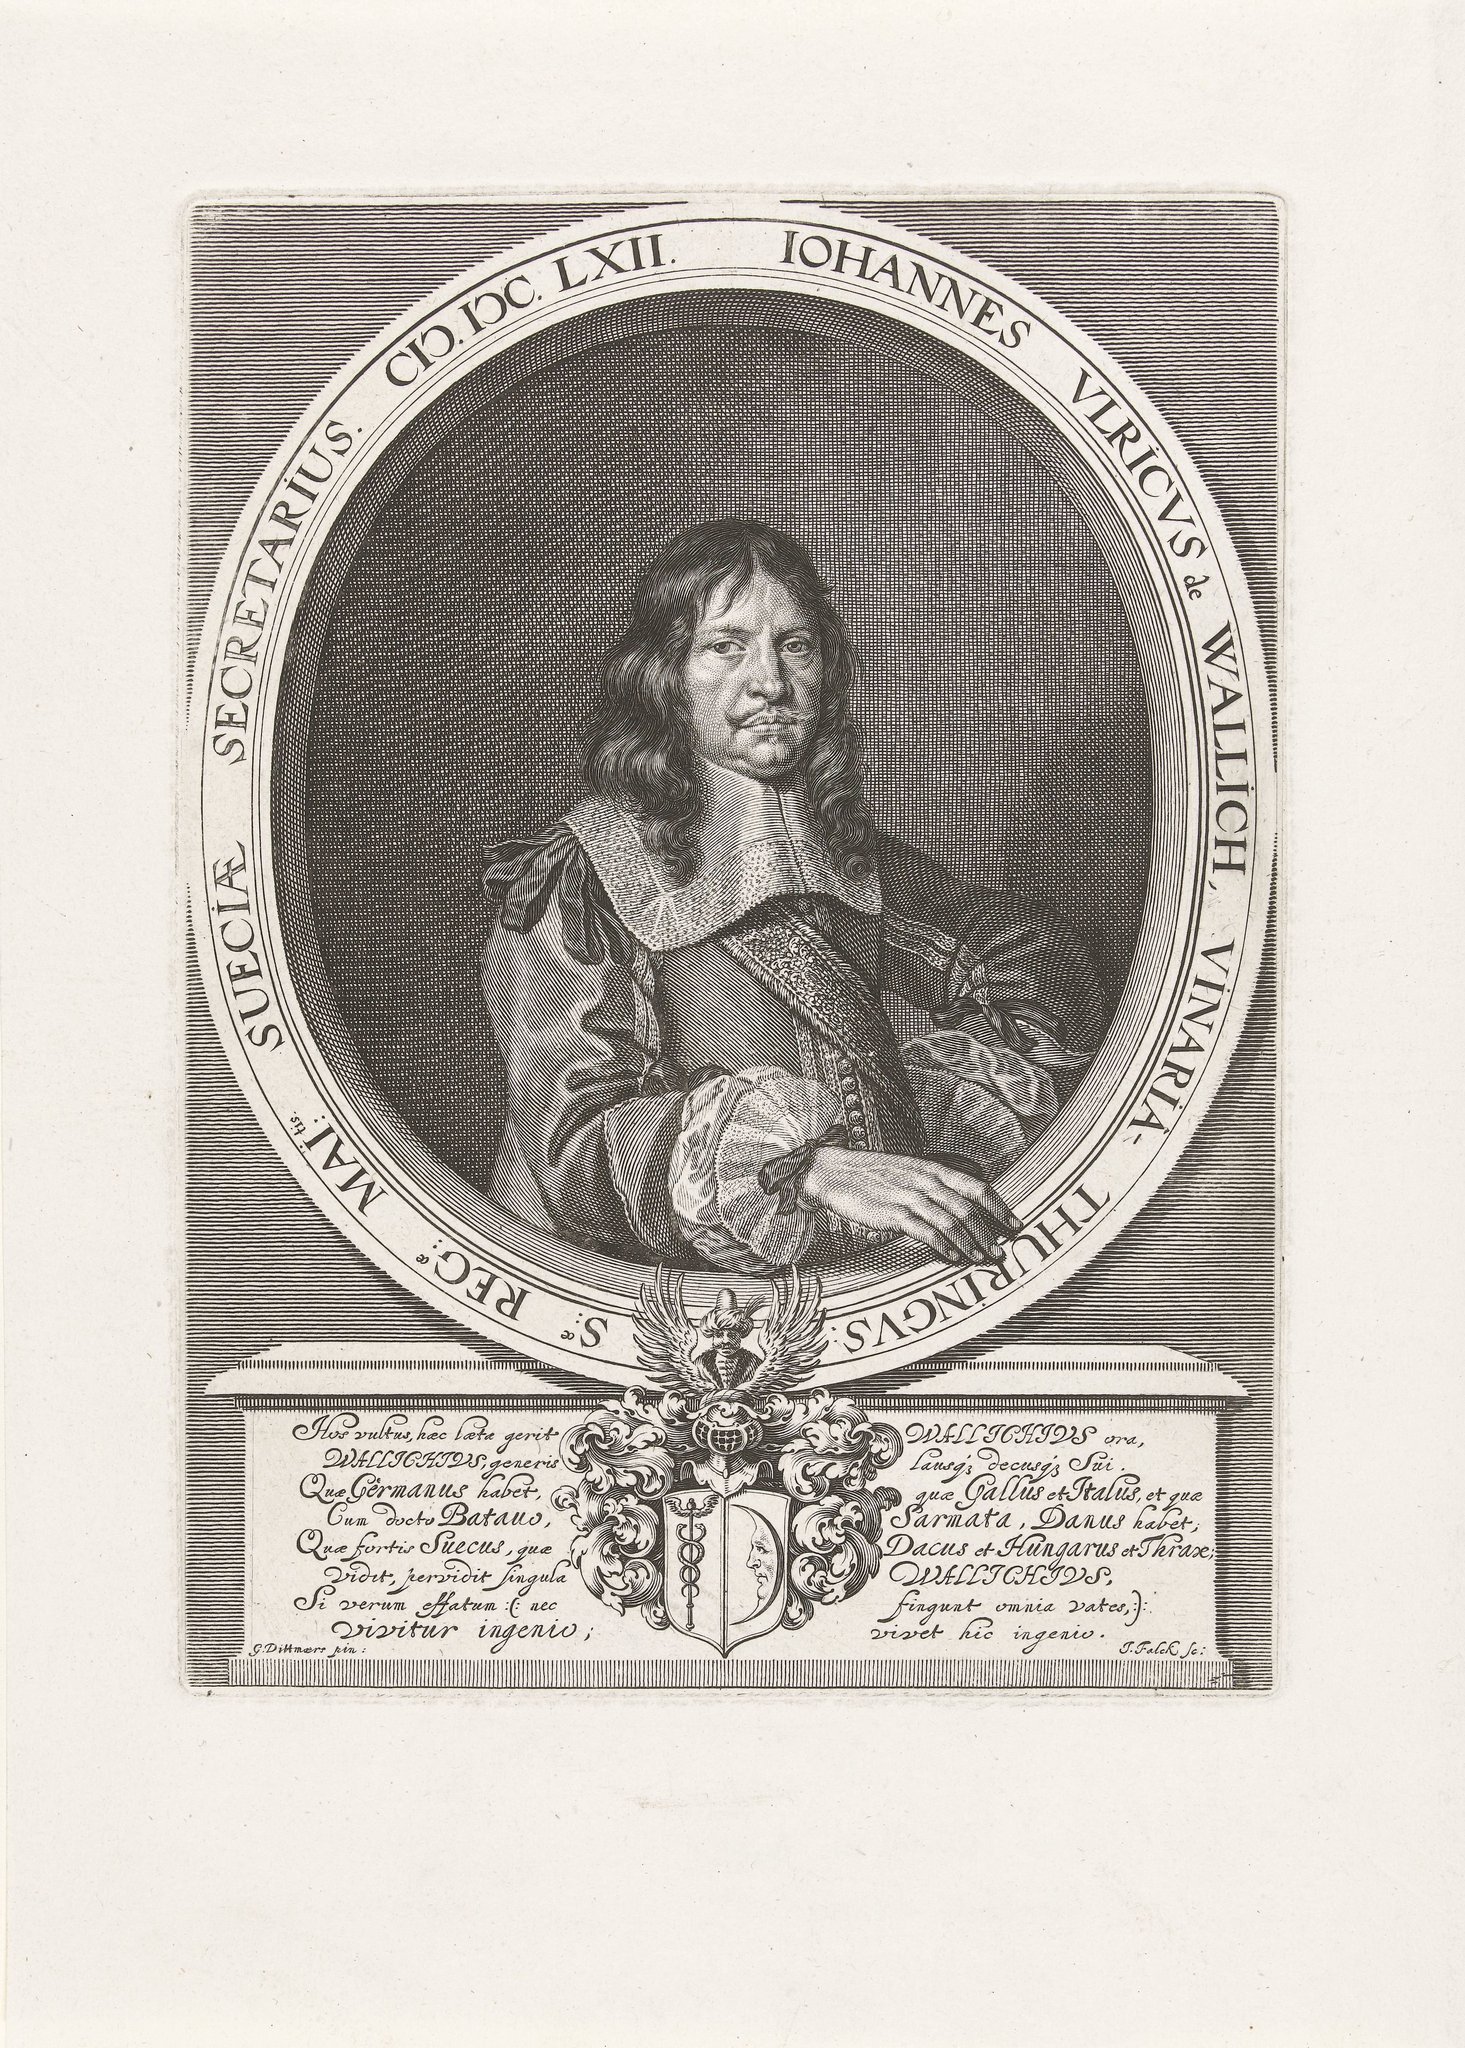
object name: print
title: Portret van Johann Ulrich von Wallich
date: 1662-1677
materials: paper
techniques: engraving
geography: hamburg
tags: jurist, johann ulrich wallich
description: Portret van de Zweed Johann Ulrich von Wallich, ten halven lijve afgebeeld met linker hand in de zij en rechter over de lijst heen. Onder de lijst een console met een wapen en aan weerszijden tekst in Latijn.